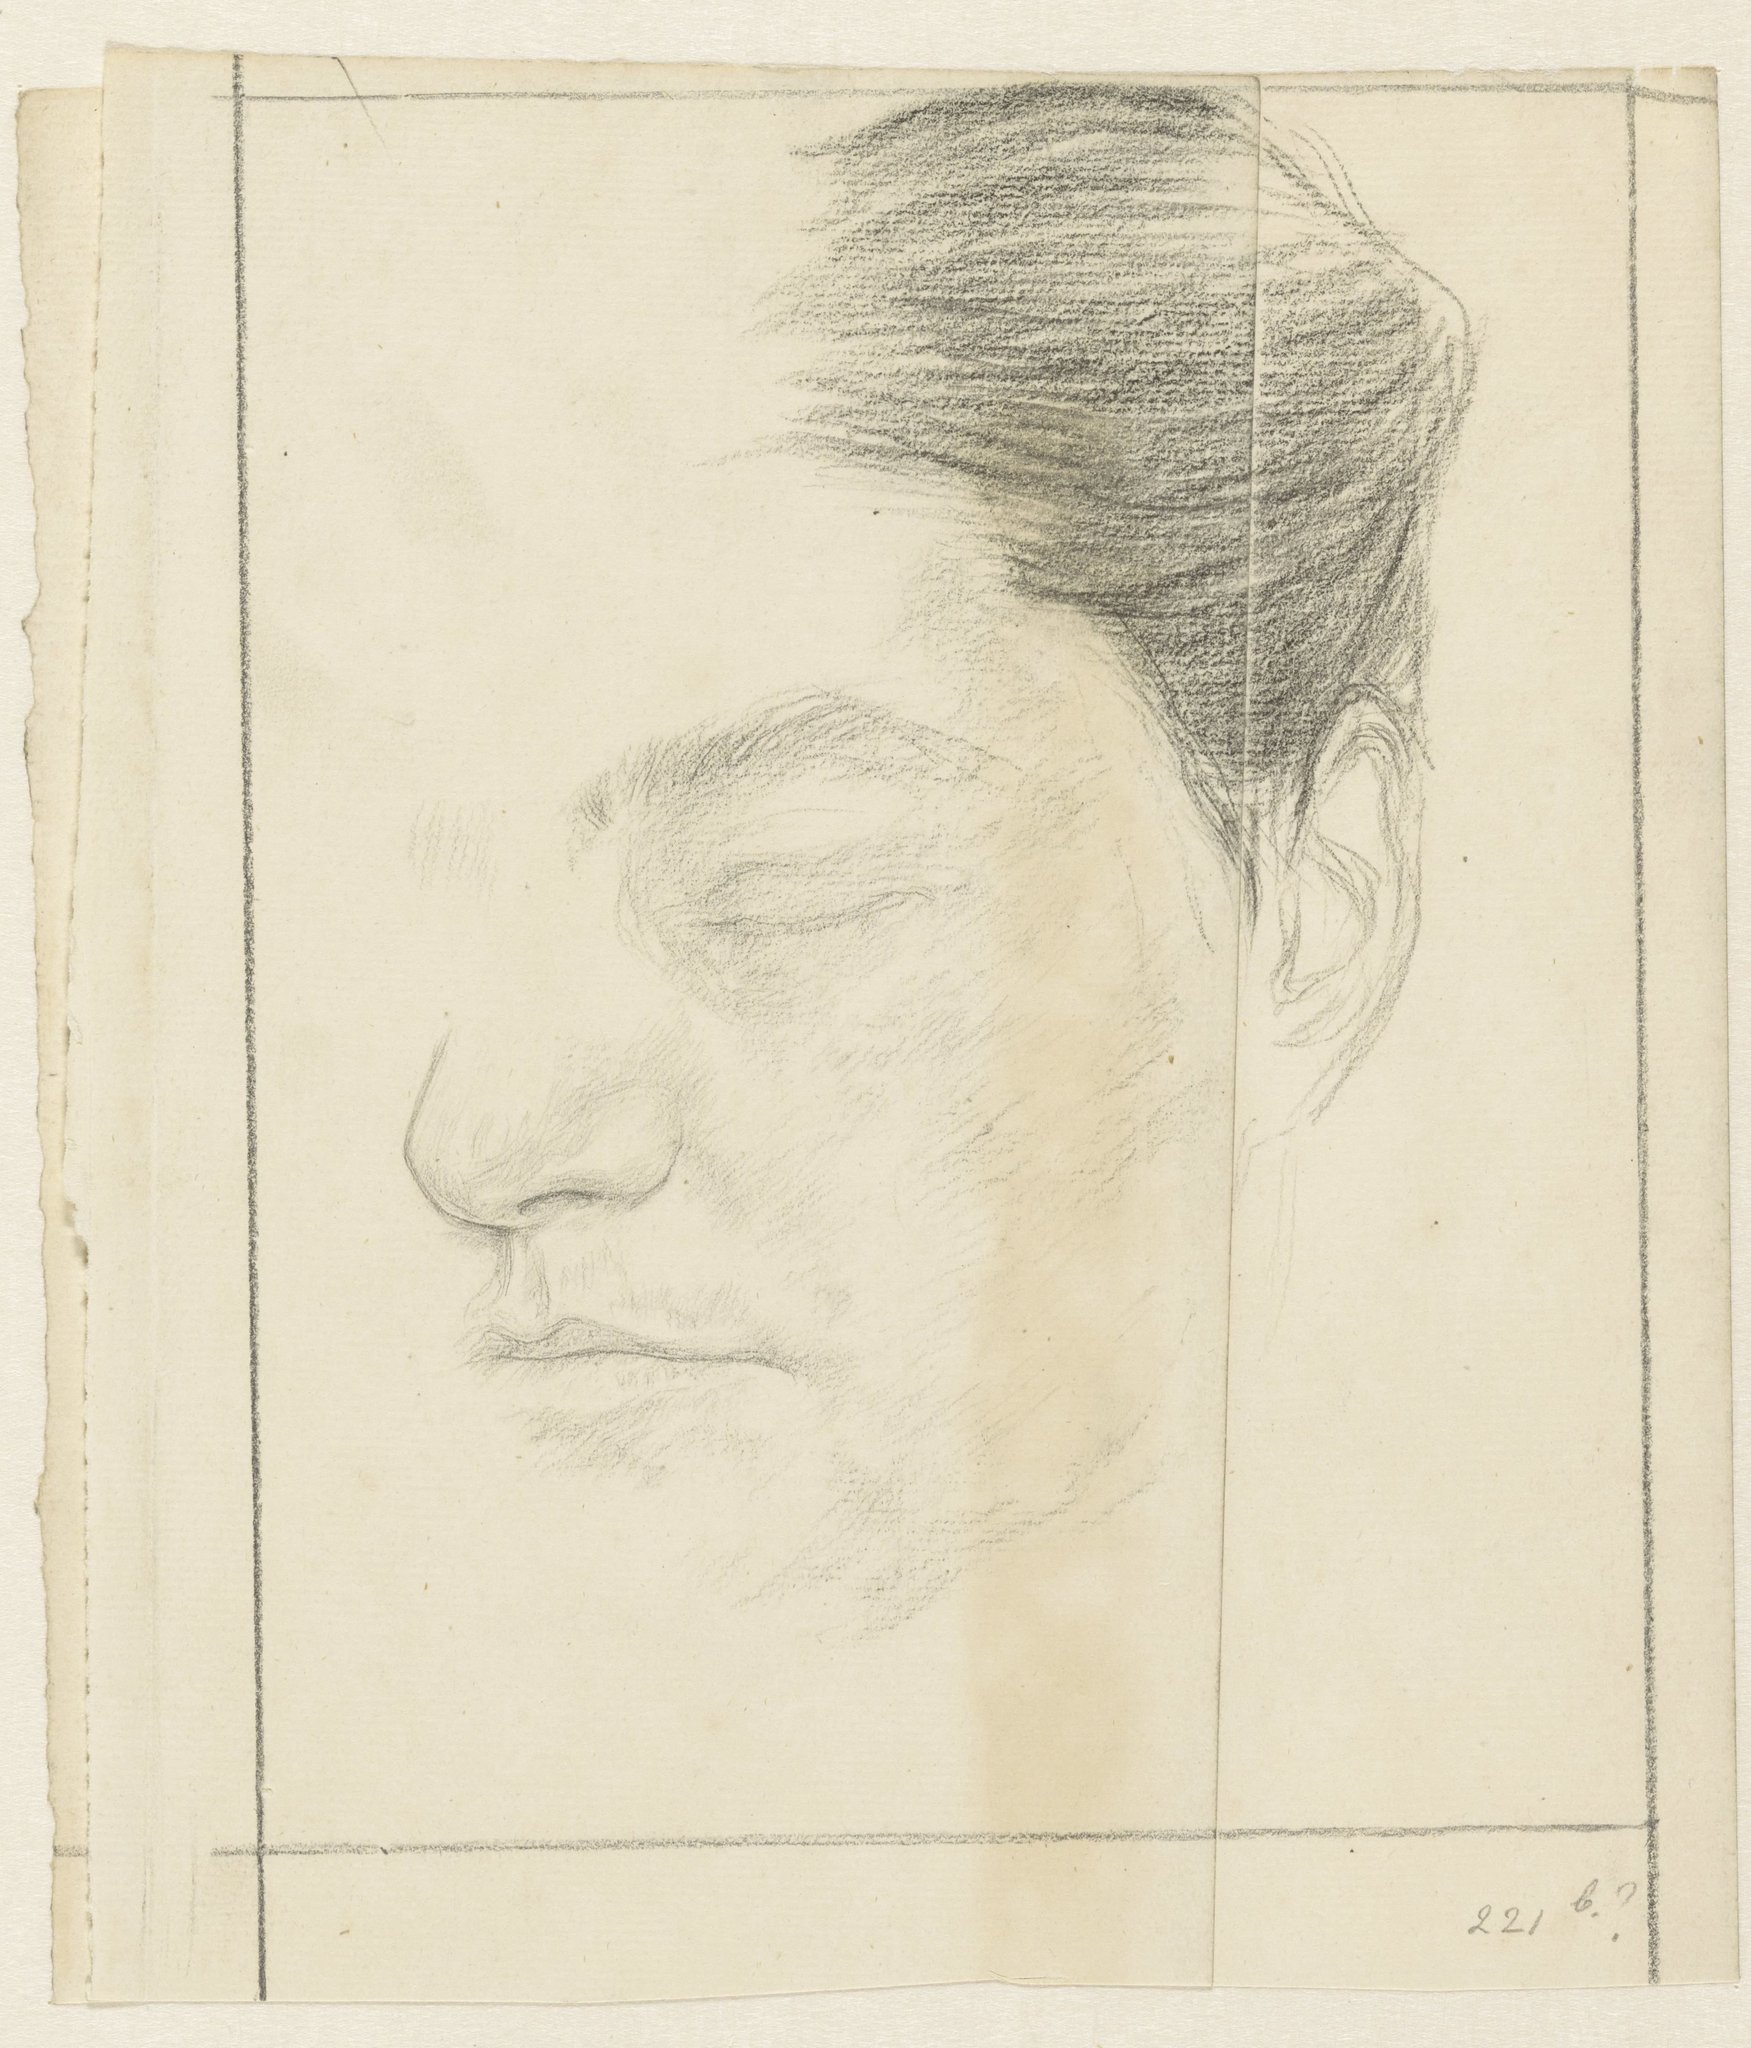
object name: drawing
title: Kopstudie, met gesloten ogen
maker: jan veth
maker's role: designer, draughtsman, painter, print maker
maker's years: 1864-1925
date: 1874-1925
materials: chalk, paper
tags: anonymous historical person portrayed alone